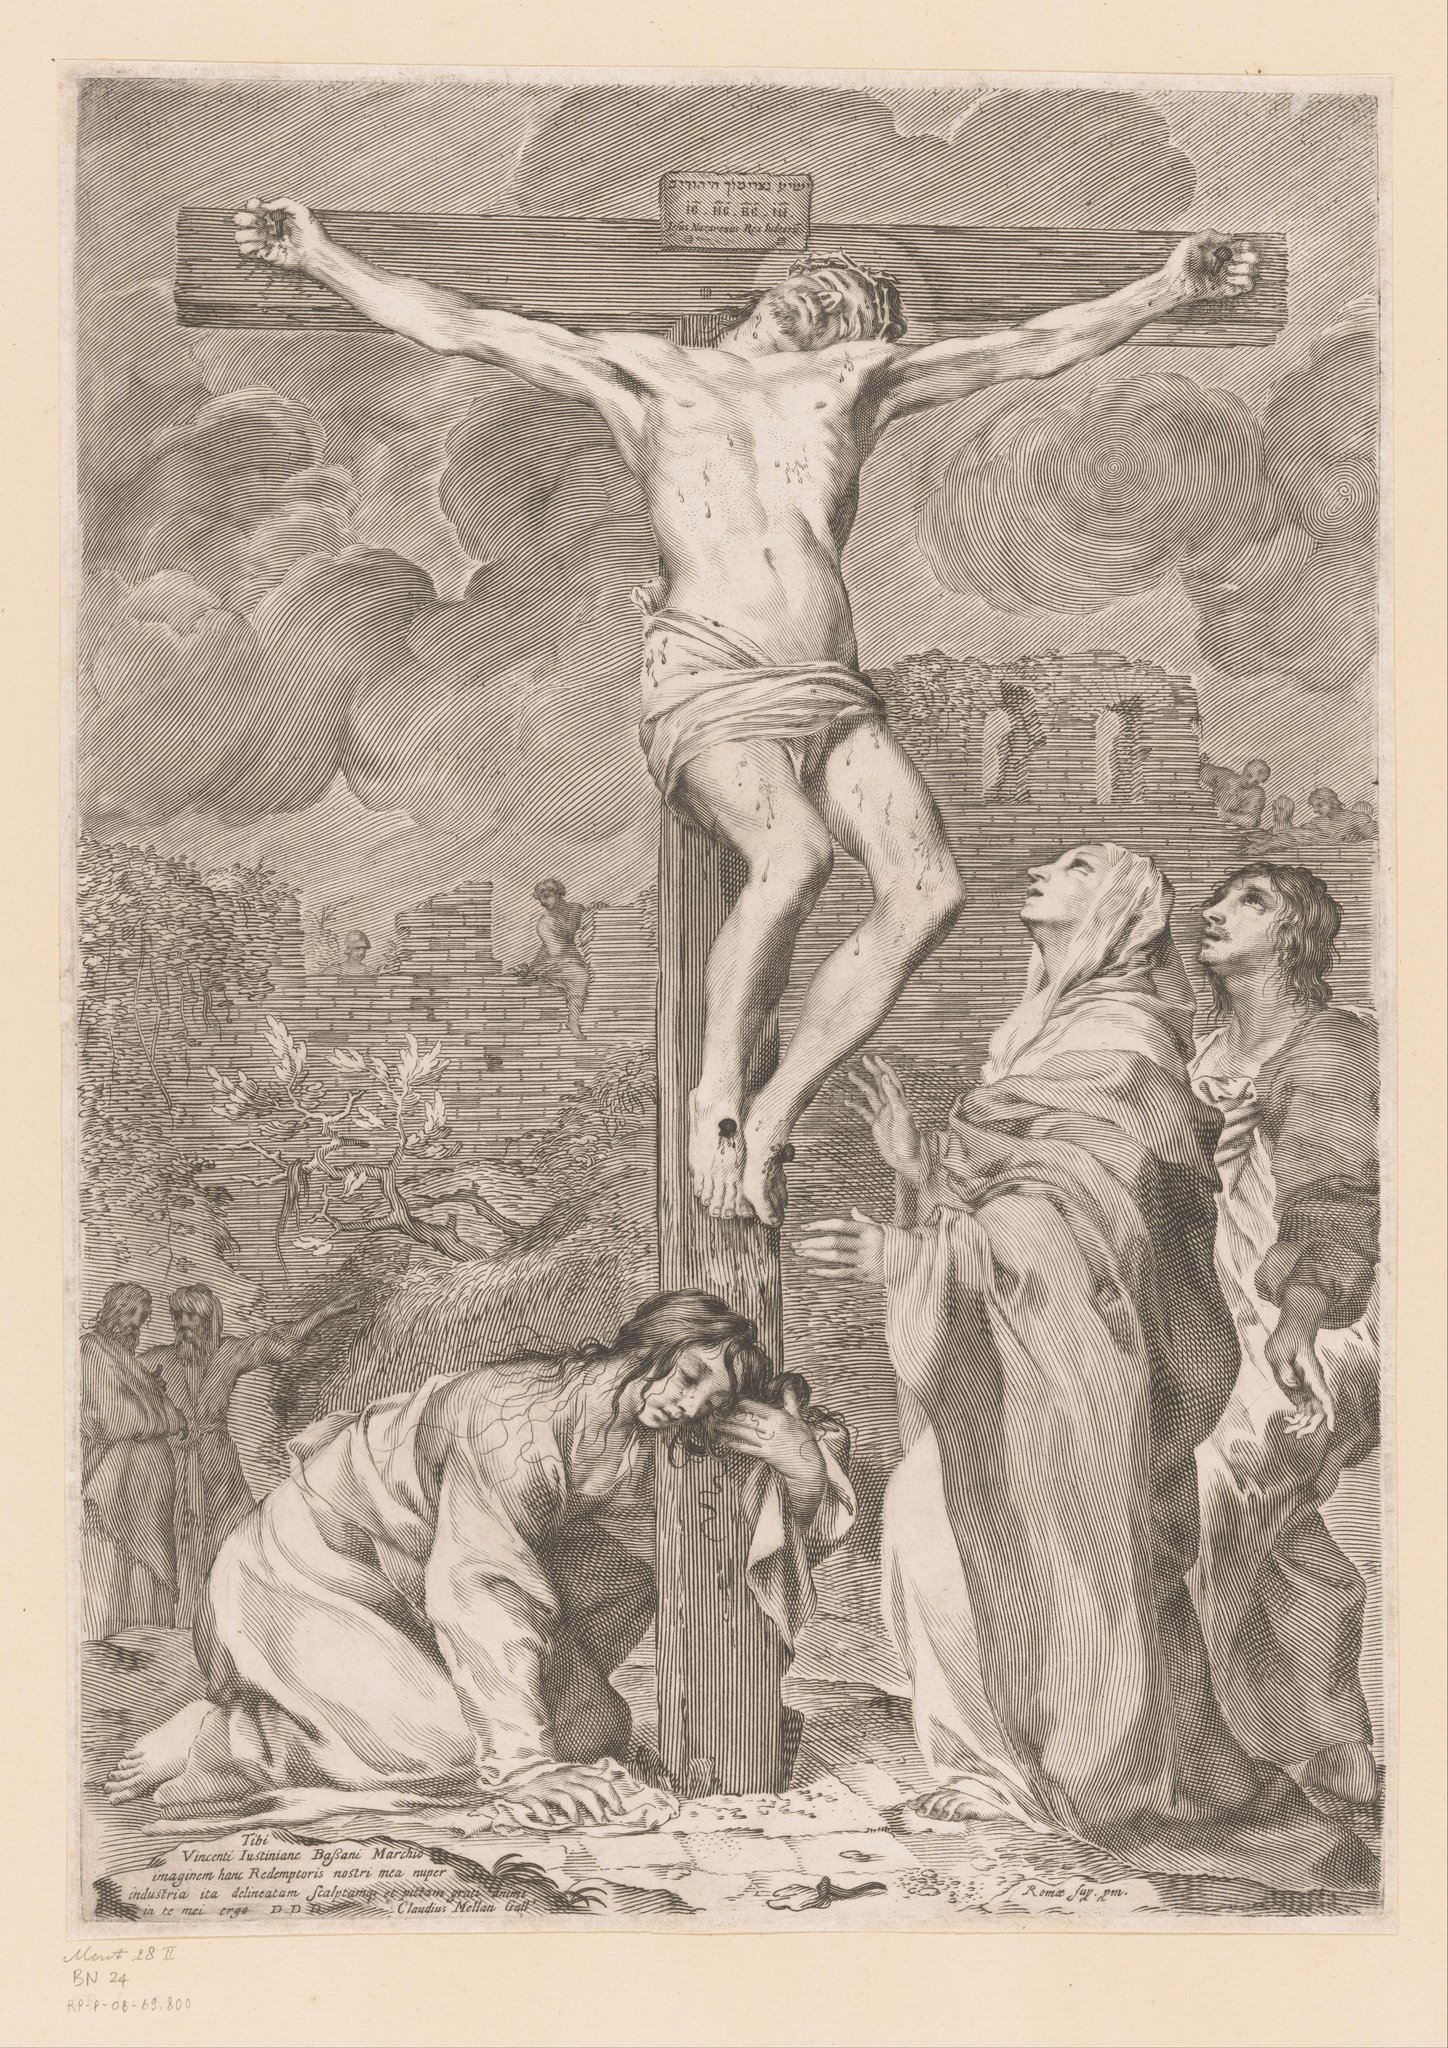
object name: print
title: Kruisiging van Christus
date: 1624-1636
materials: paper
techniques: engraving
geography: rome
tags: crucified christ with mary, john, and mary magdalene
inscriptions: collector's mark: Lugt 240